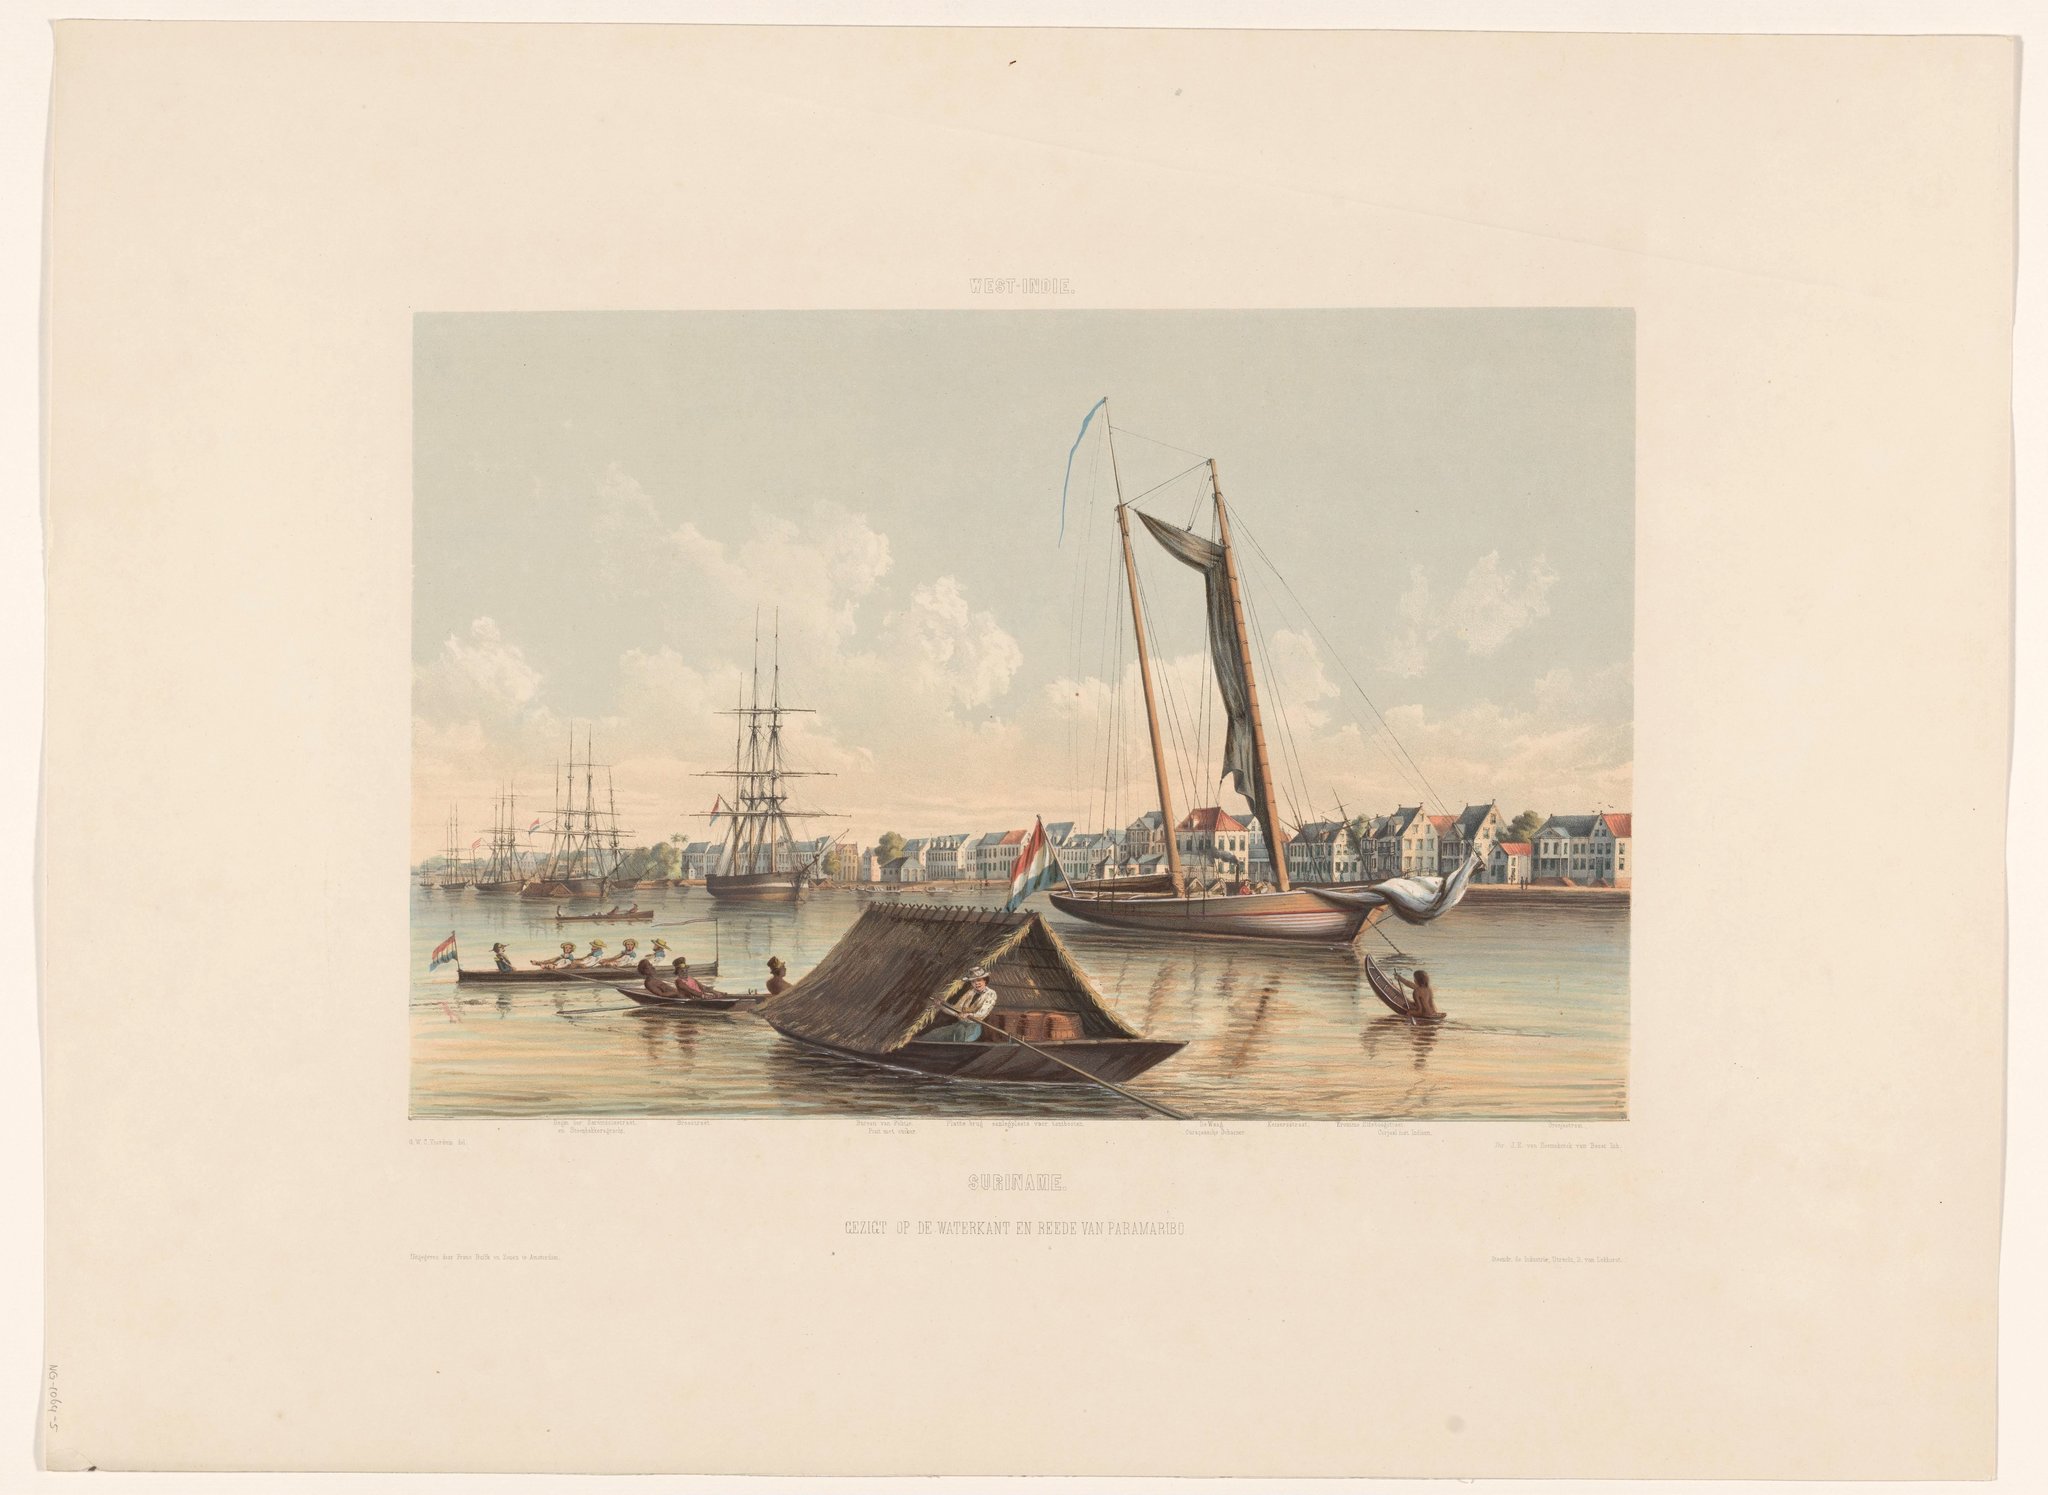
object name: print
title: Suriname. Gezigt op de Waterkant en reede van Paramaribo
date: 1860-1862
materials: paper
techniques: lithograph, hand coloring, lacquer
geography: netherlands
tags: prospect of city, town panorama, silhouette of city (+ city(-scape) with figures, staffage), suriname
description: Gezicht vanaf het water op de Waterkant in Paramaribo. Op het water allerlei verschillende soorten vaartuigen. Op de plaat staan de volgende straten aangegeven: Saramaccastraat, Steenbakkersgracht, Breestraat, de Waag, Keizersstraat, Kromme Elleboogstraat en de Oranjestraat. Onderdeel van het plaatwerk 'Gezigten uit Neerland's West-Indien'.